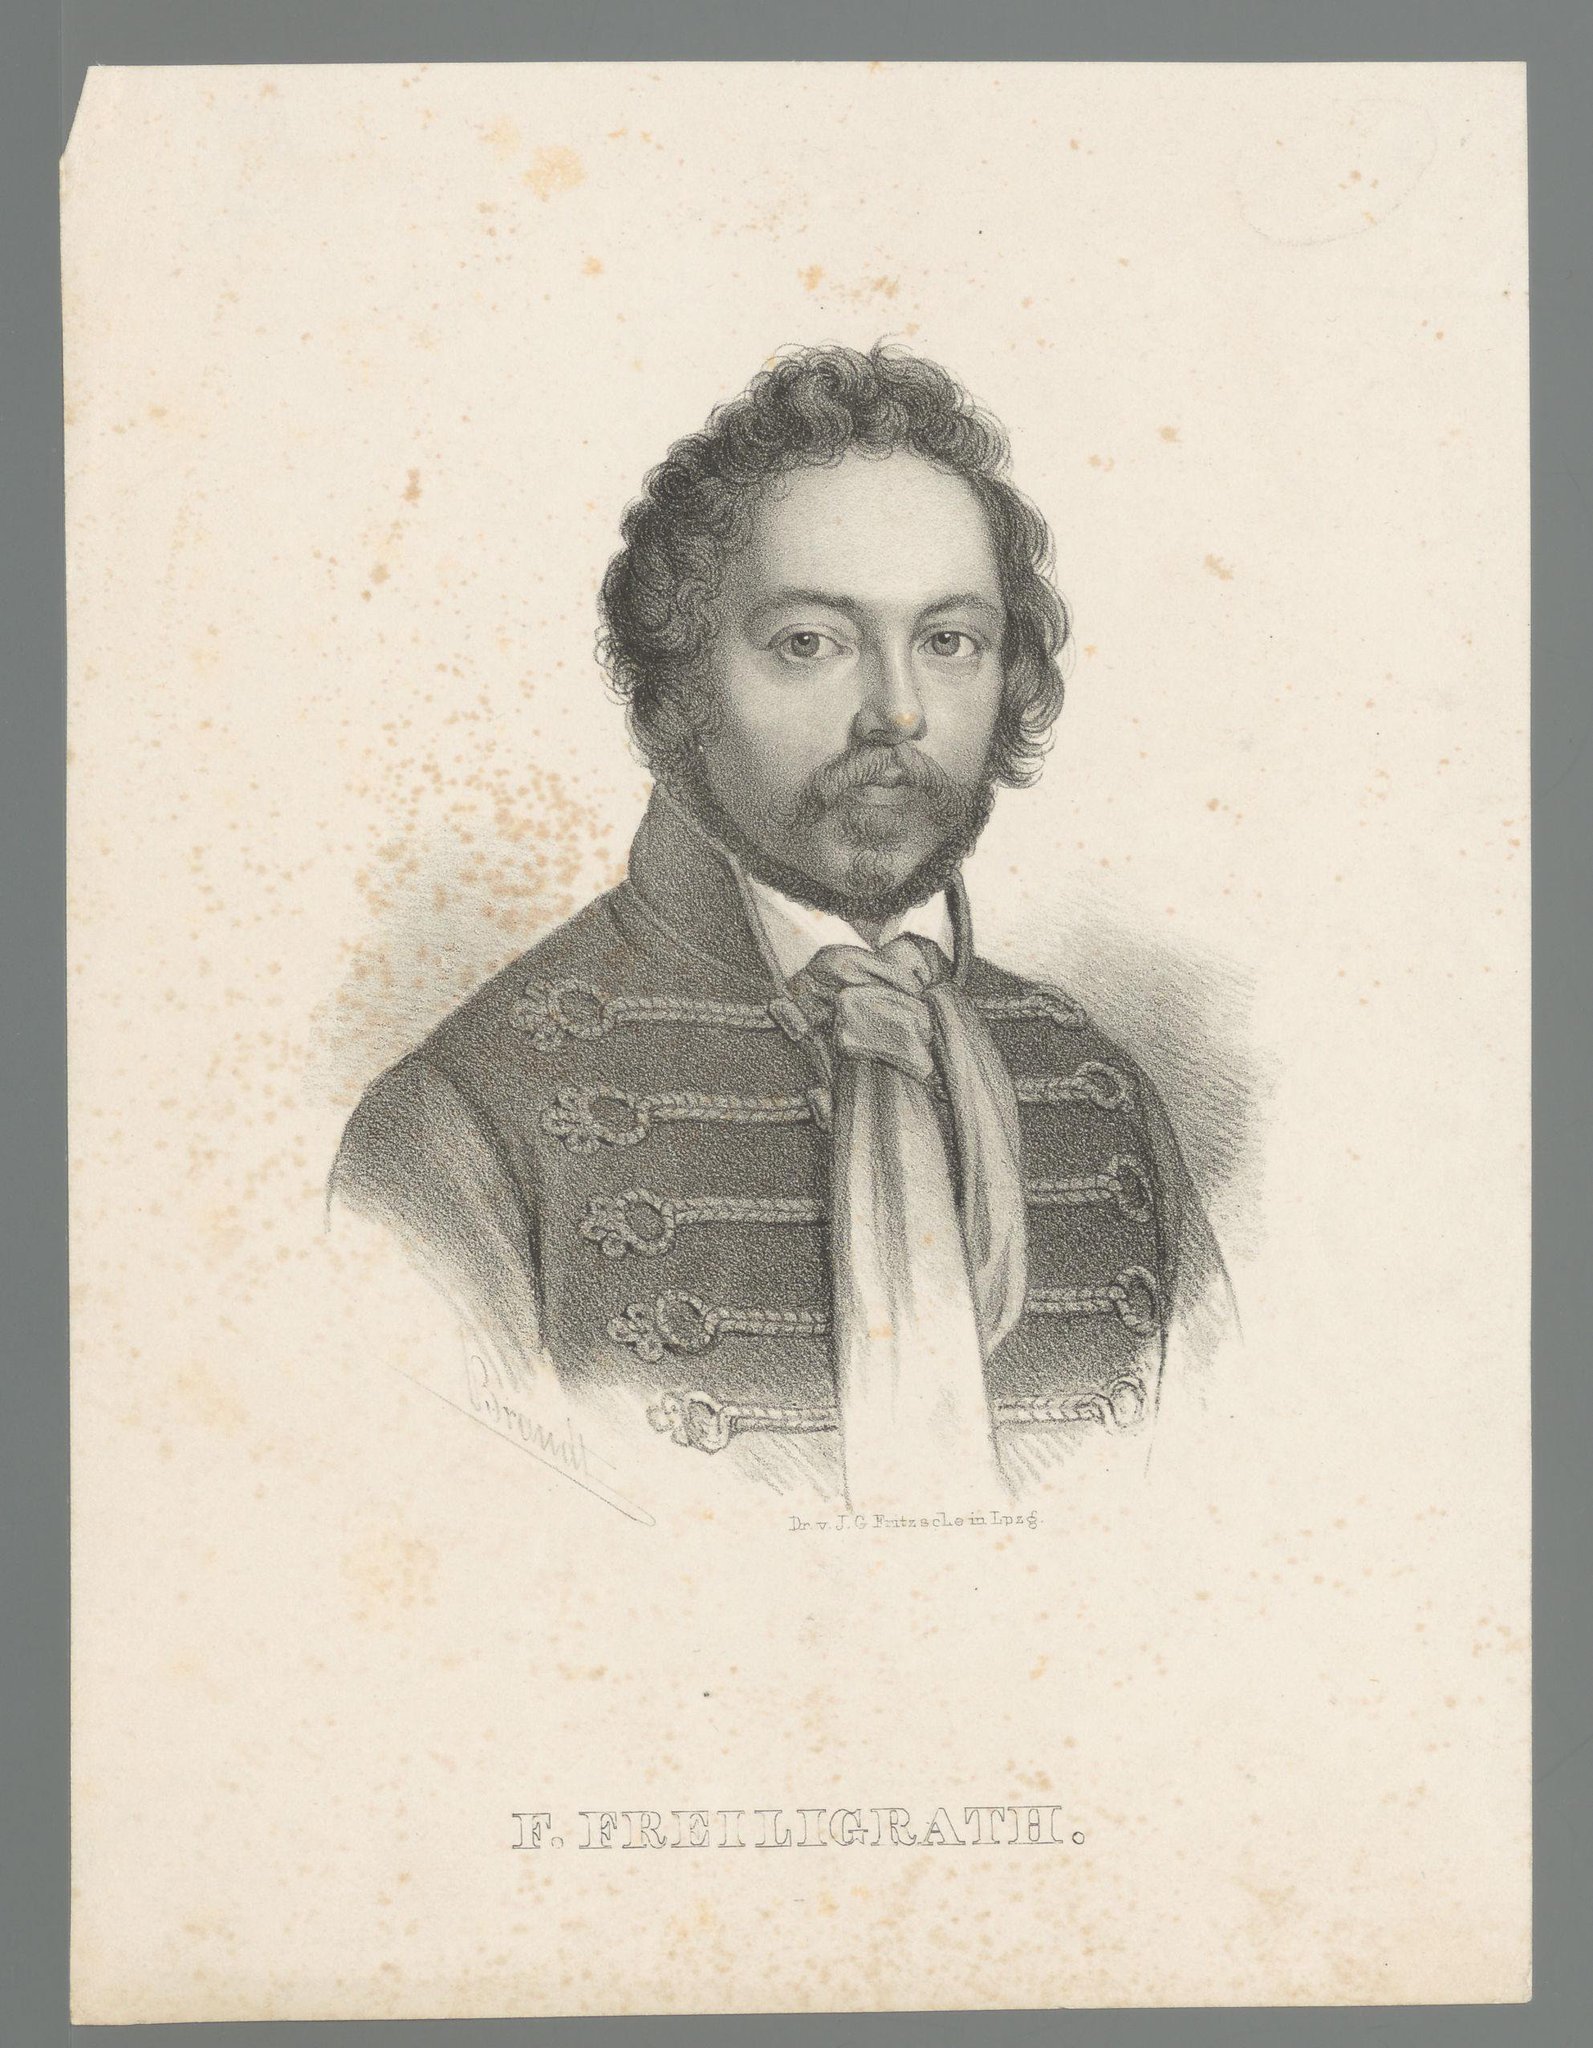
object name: print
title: Portret van Ferdinand Freiligrath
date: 1820-1850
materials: paper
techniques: lithograph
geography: leipzig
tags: ferdinand freiligrath, adult man, historical persons, beard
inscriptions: collector's mark: Lugt 2228